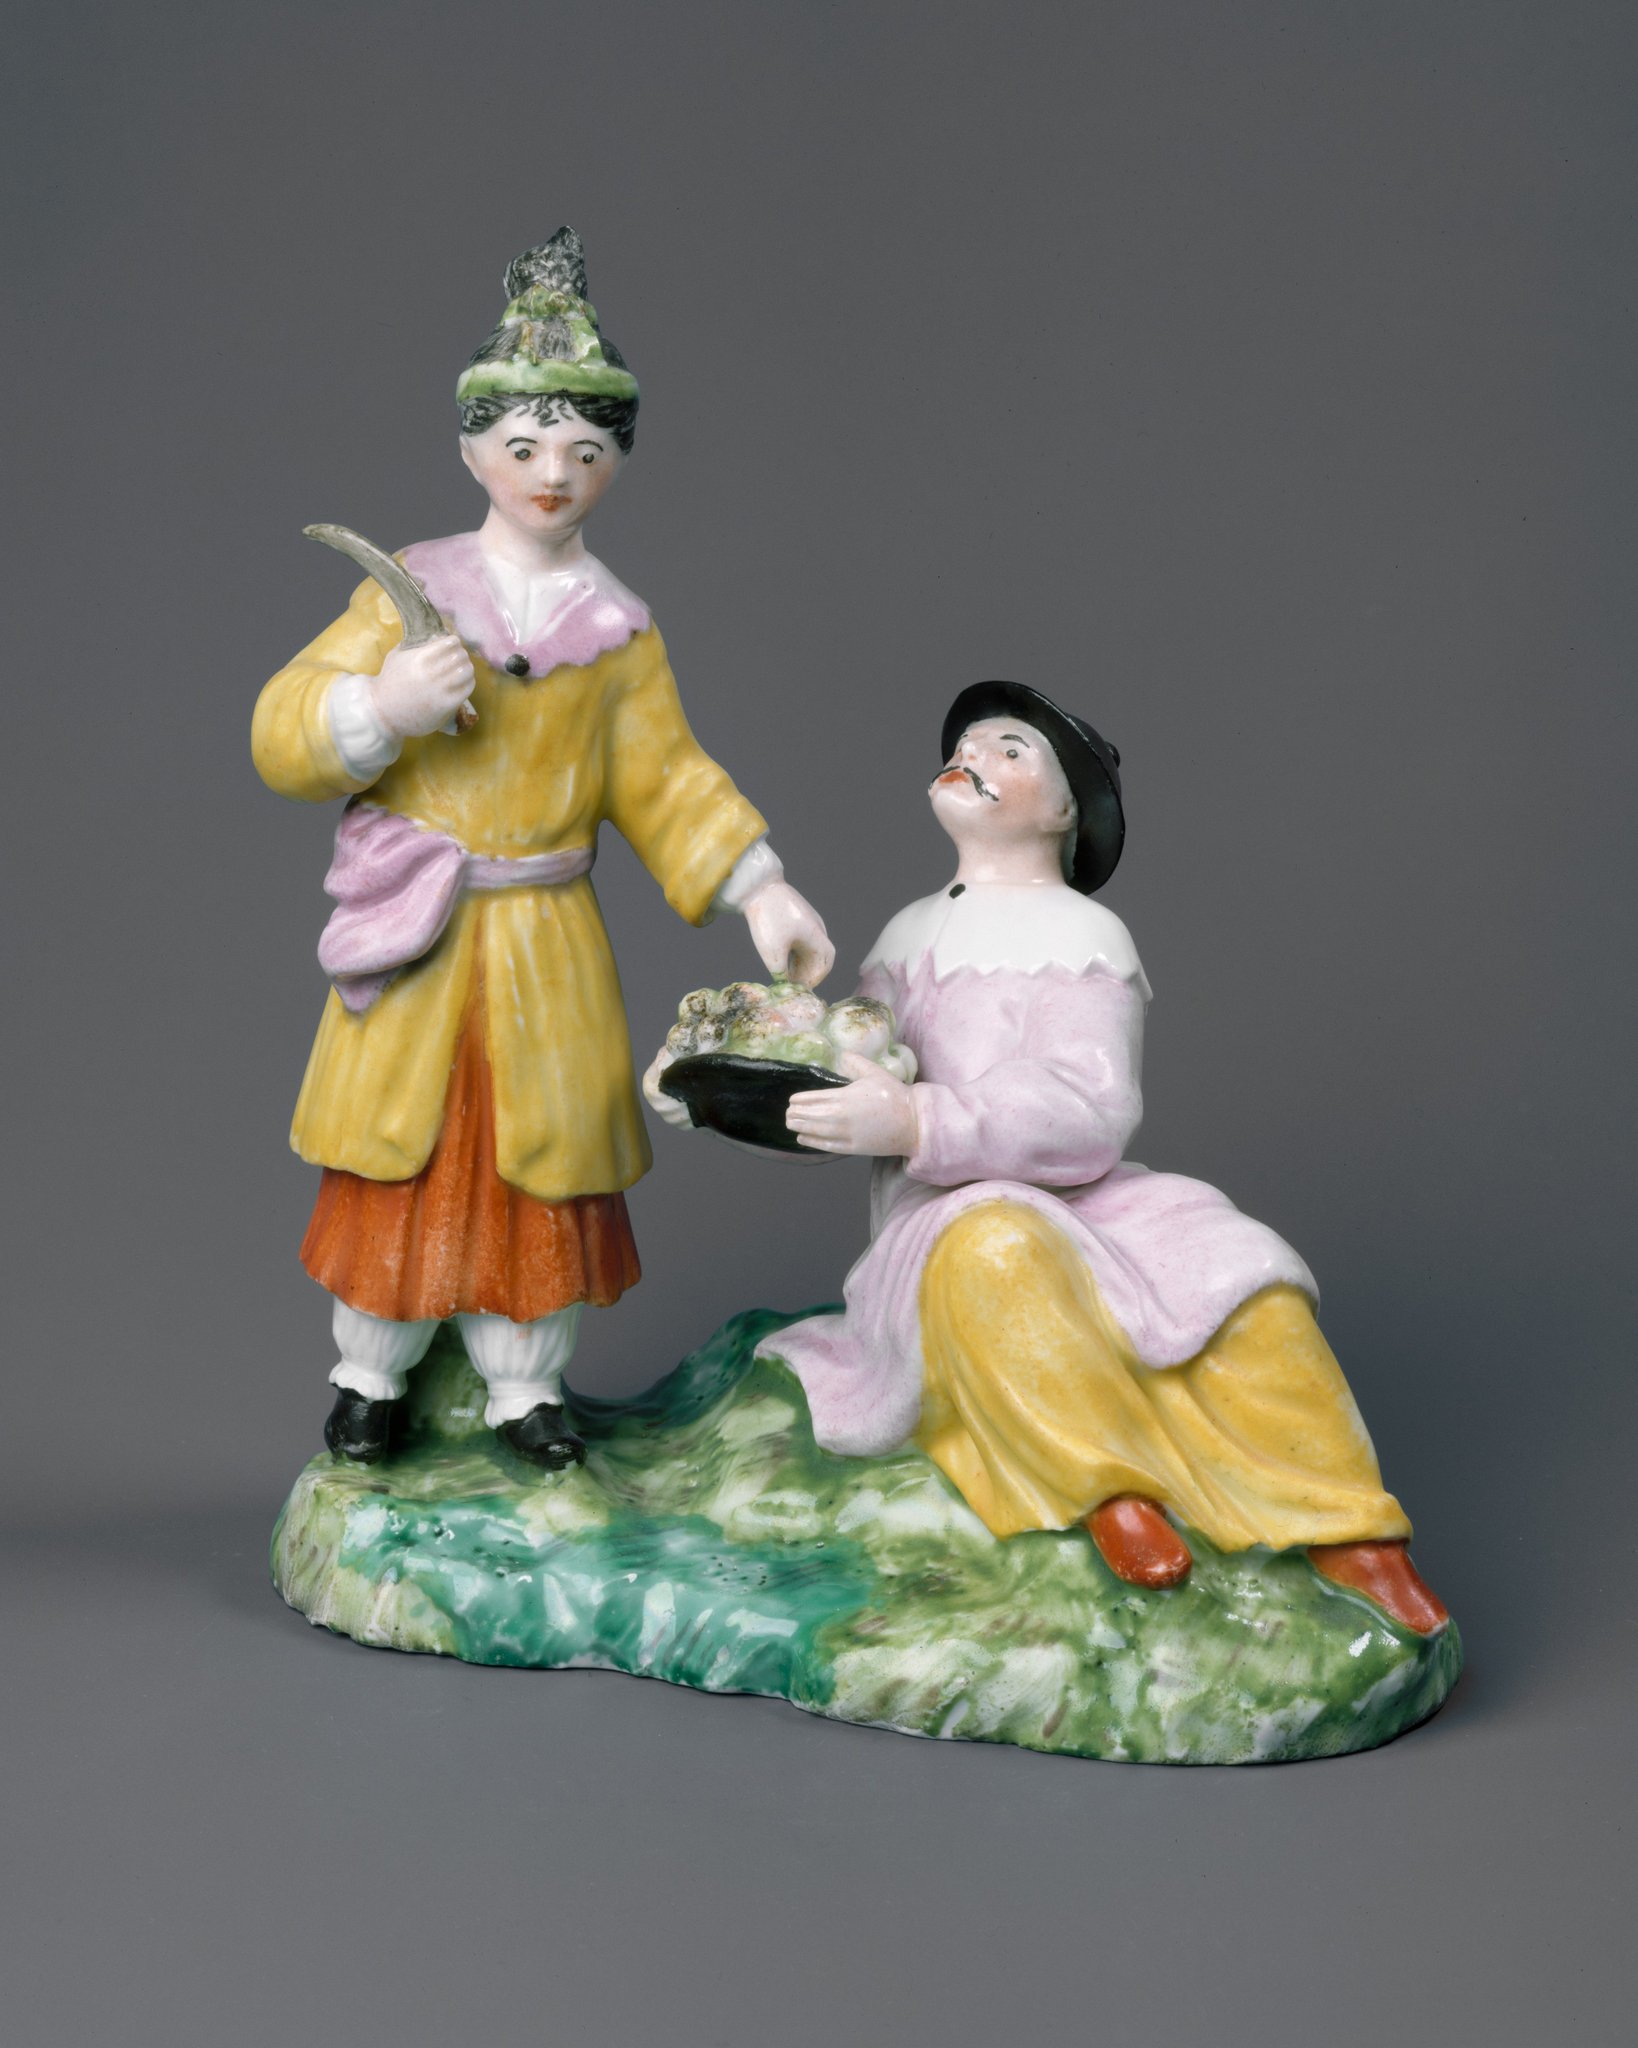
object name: group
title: Orientals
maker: royal porcelain manufactory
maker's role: factory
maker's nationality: danish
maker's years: 1775-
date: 1783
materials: hard paste porcelain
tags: knives,men